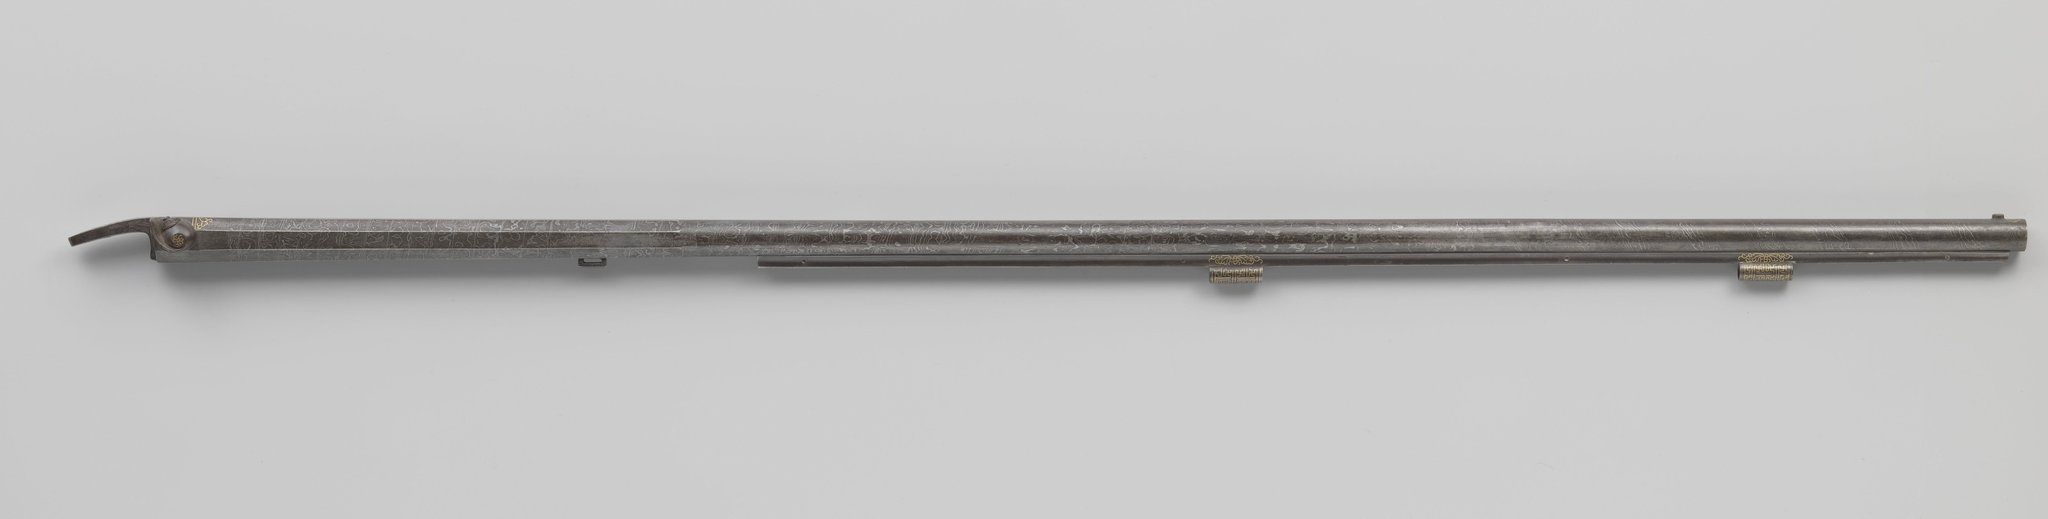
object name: barrel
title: Loop van een percussiegeweer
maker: Anonymous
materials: iron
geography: india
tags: lombok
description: Gladde, ronde loop van geblauwd staal, welke bij de kamer in een achtkantig gedeelte overgaat. Aan de achterkant van de kamer is een percussiekamer met ingetapte (gedeeltelijk afgebroken) percussieschouw. Op het voorste gedeelte van de loop is een vizierkorrel. Aan de onderkant van de loop is een platte band, met op de smalle kant een uitholling voor de laadstok en twee laadstokdragers; het geheel is door middel van bouten aan de loop bevestigd. De loop is van namaak gedamasceneerd staal (de tekening der banden is verkregen door etsing). De laadstokdragers, de platte band bij de laadstokdragers en de kamer zijn met koper geïncrusteerd in de vorm van bloem- en bladmotieven, meanderband en geometrische motieven.